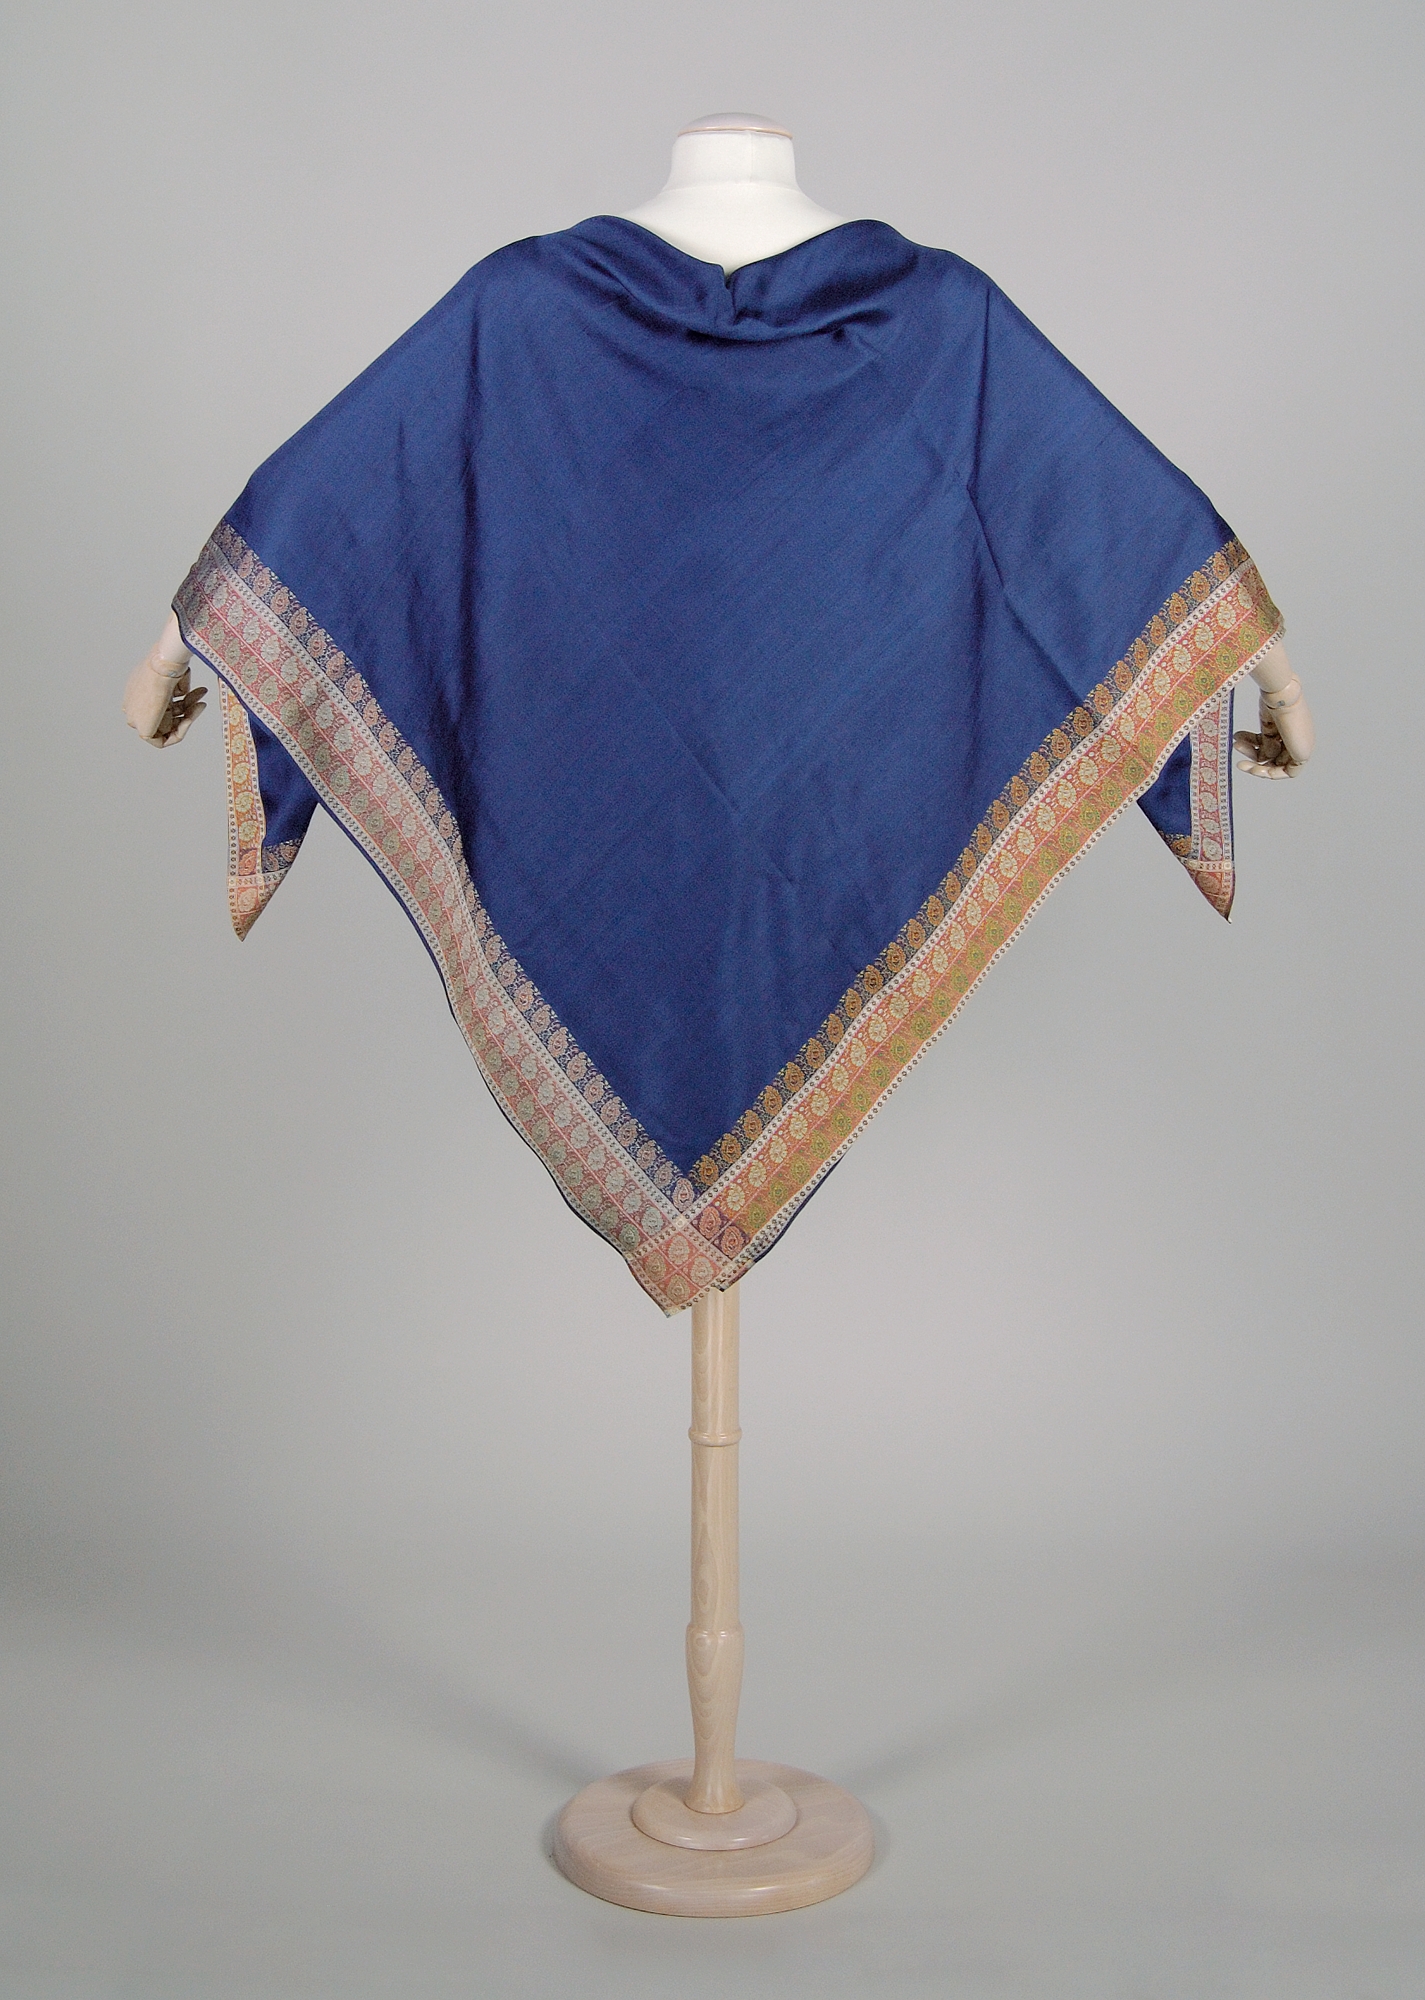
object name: shawl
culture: american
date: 1815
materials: silk, wool